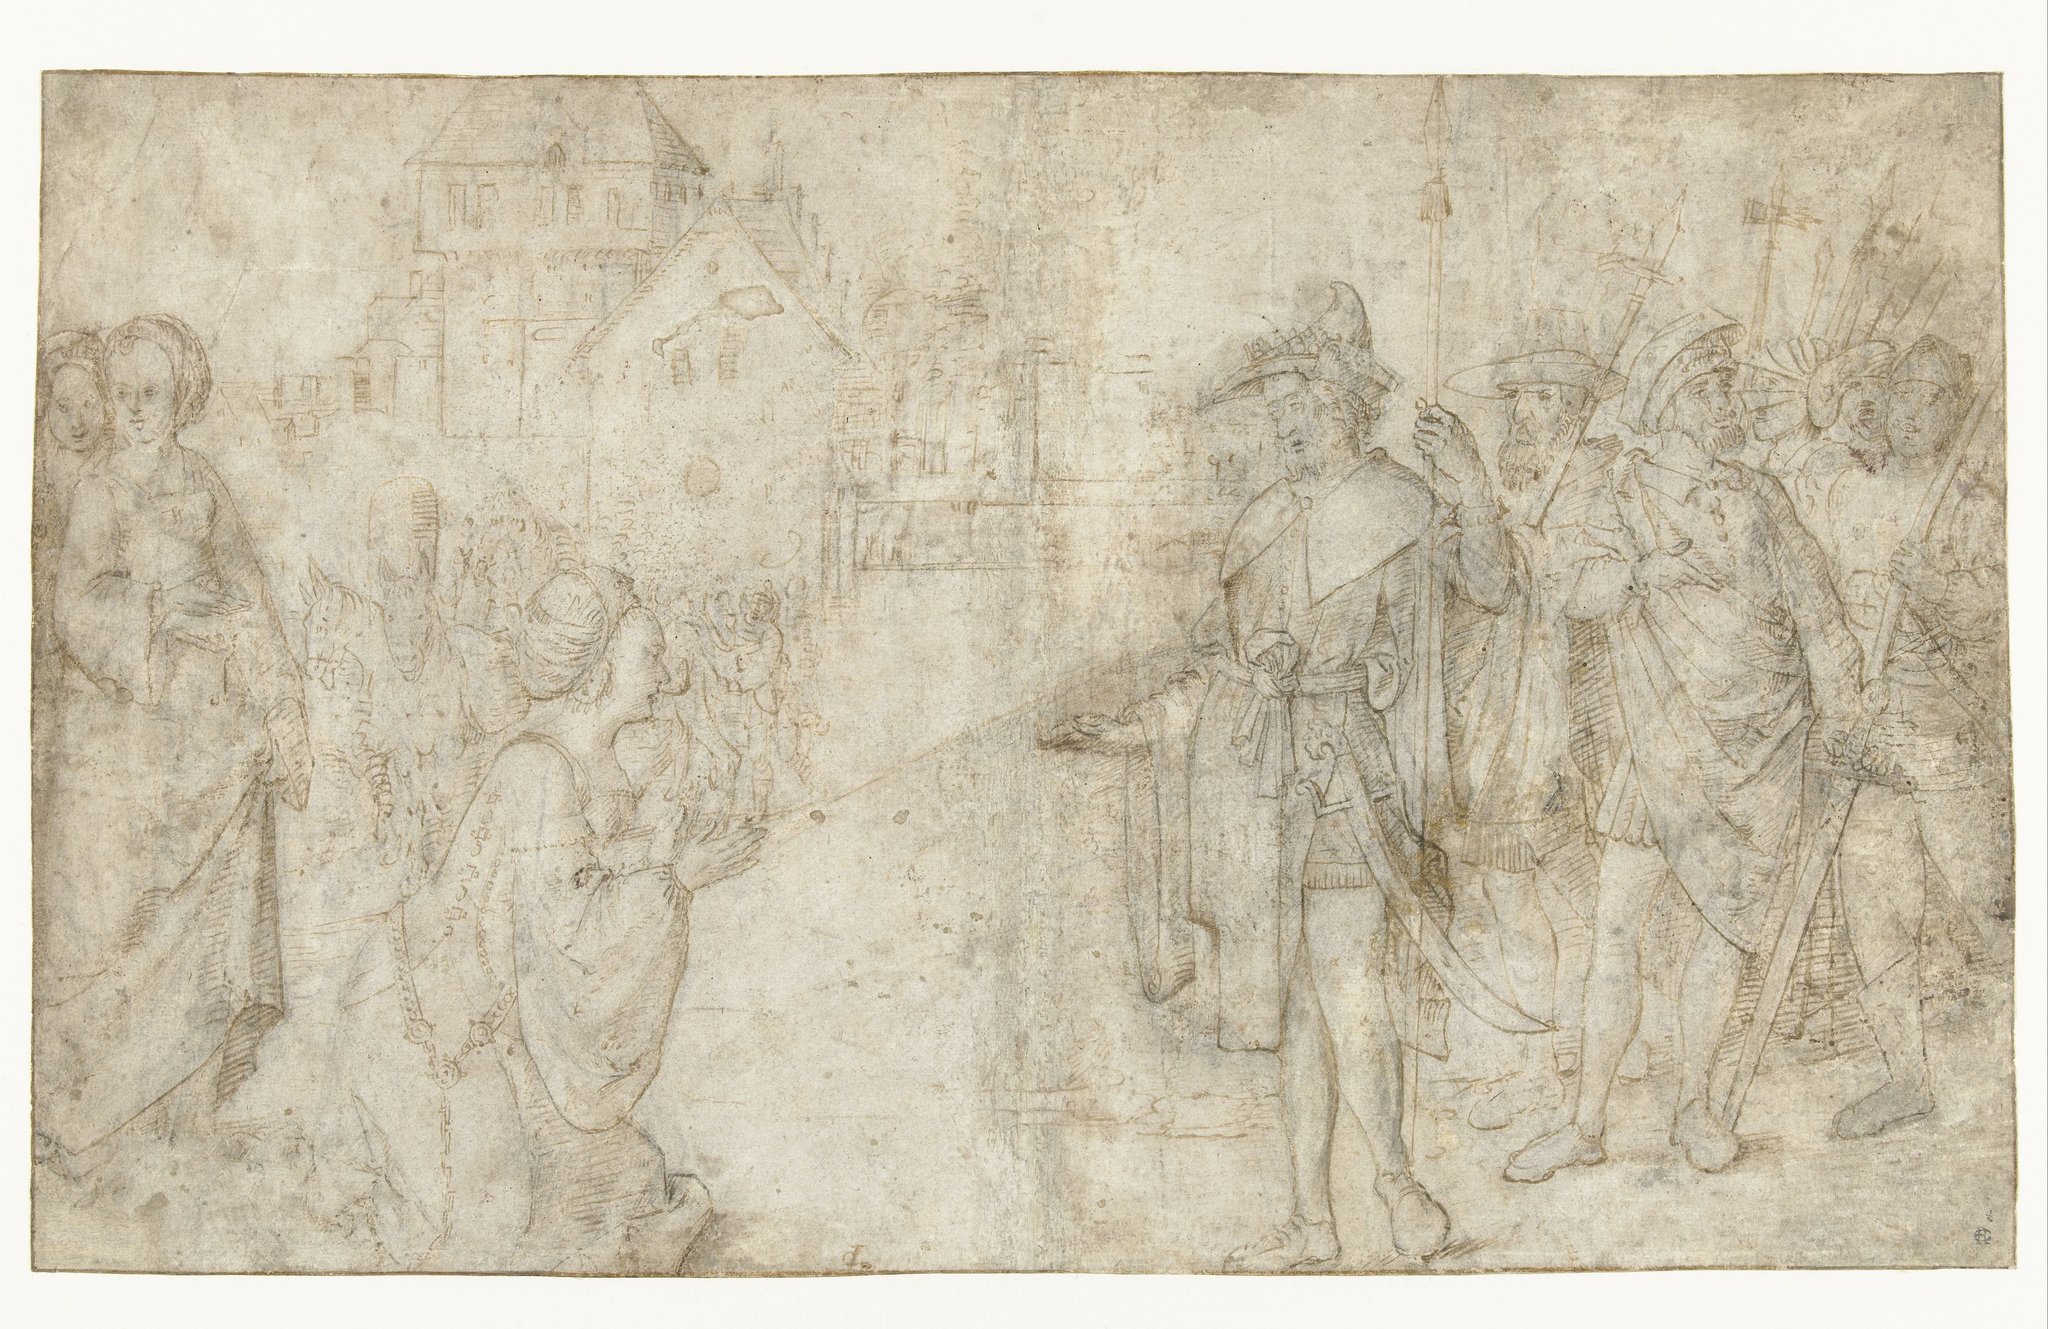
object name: drawing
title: Ontmoeting van David en Abigaïl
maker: Anonymous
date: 1515-1525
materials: chalk, ink, paper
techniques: pen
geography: southern netherlands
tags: meeting of david and abigail, who kneels before him